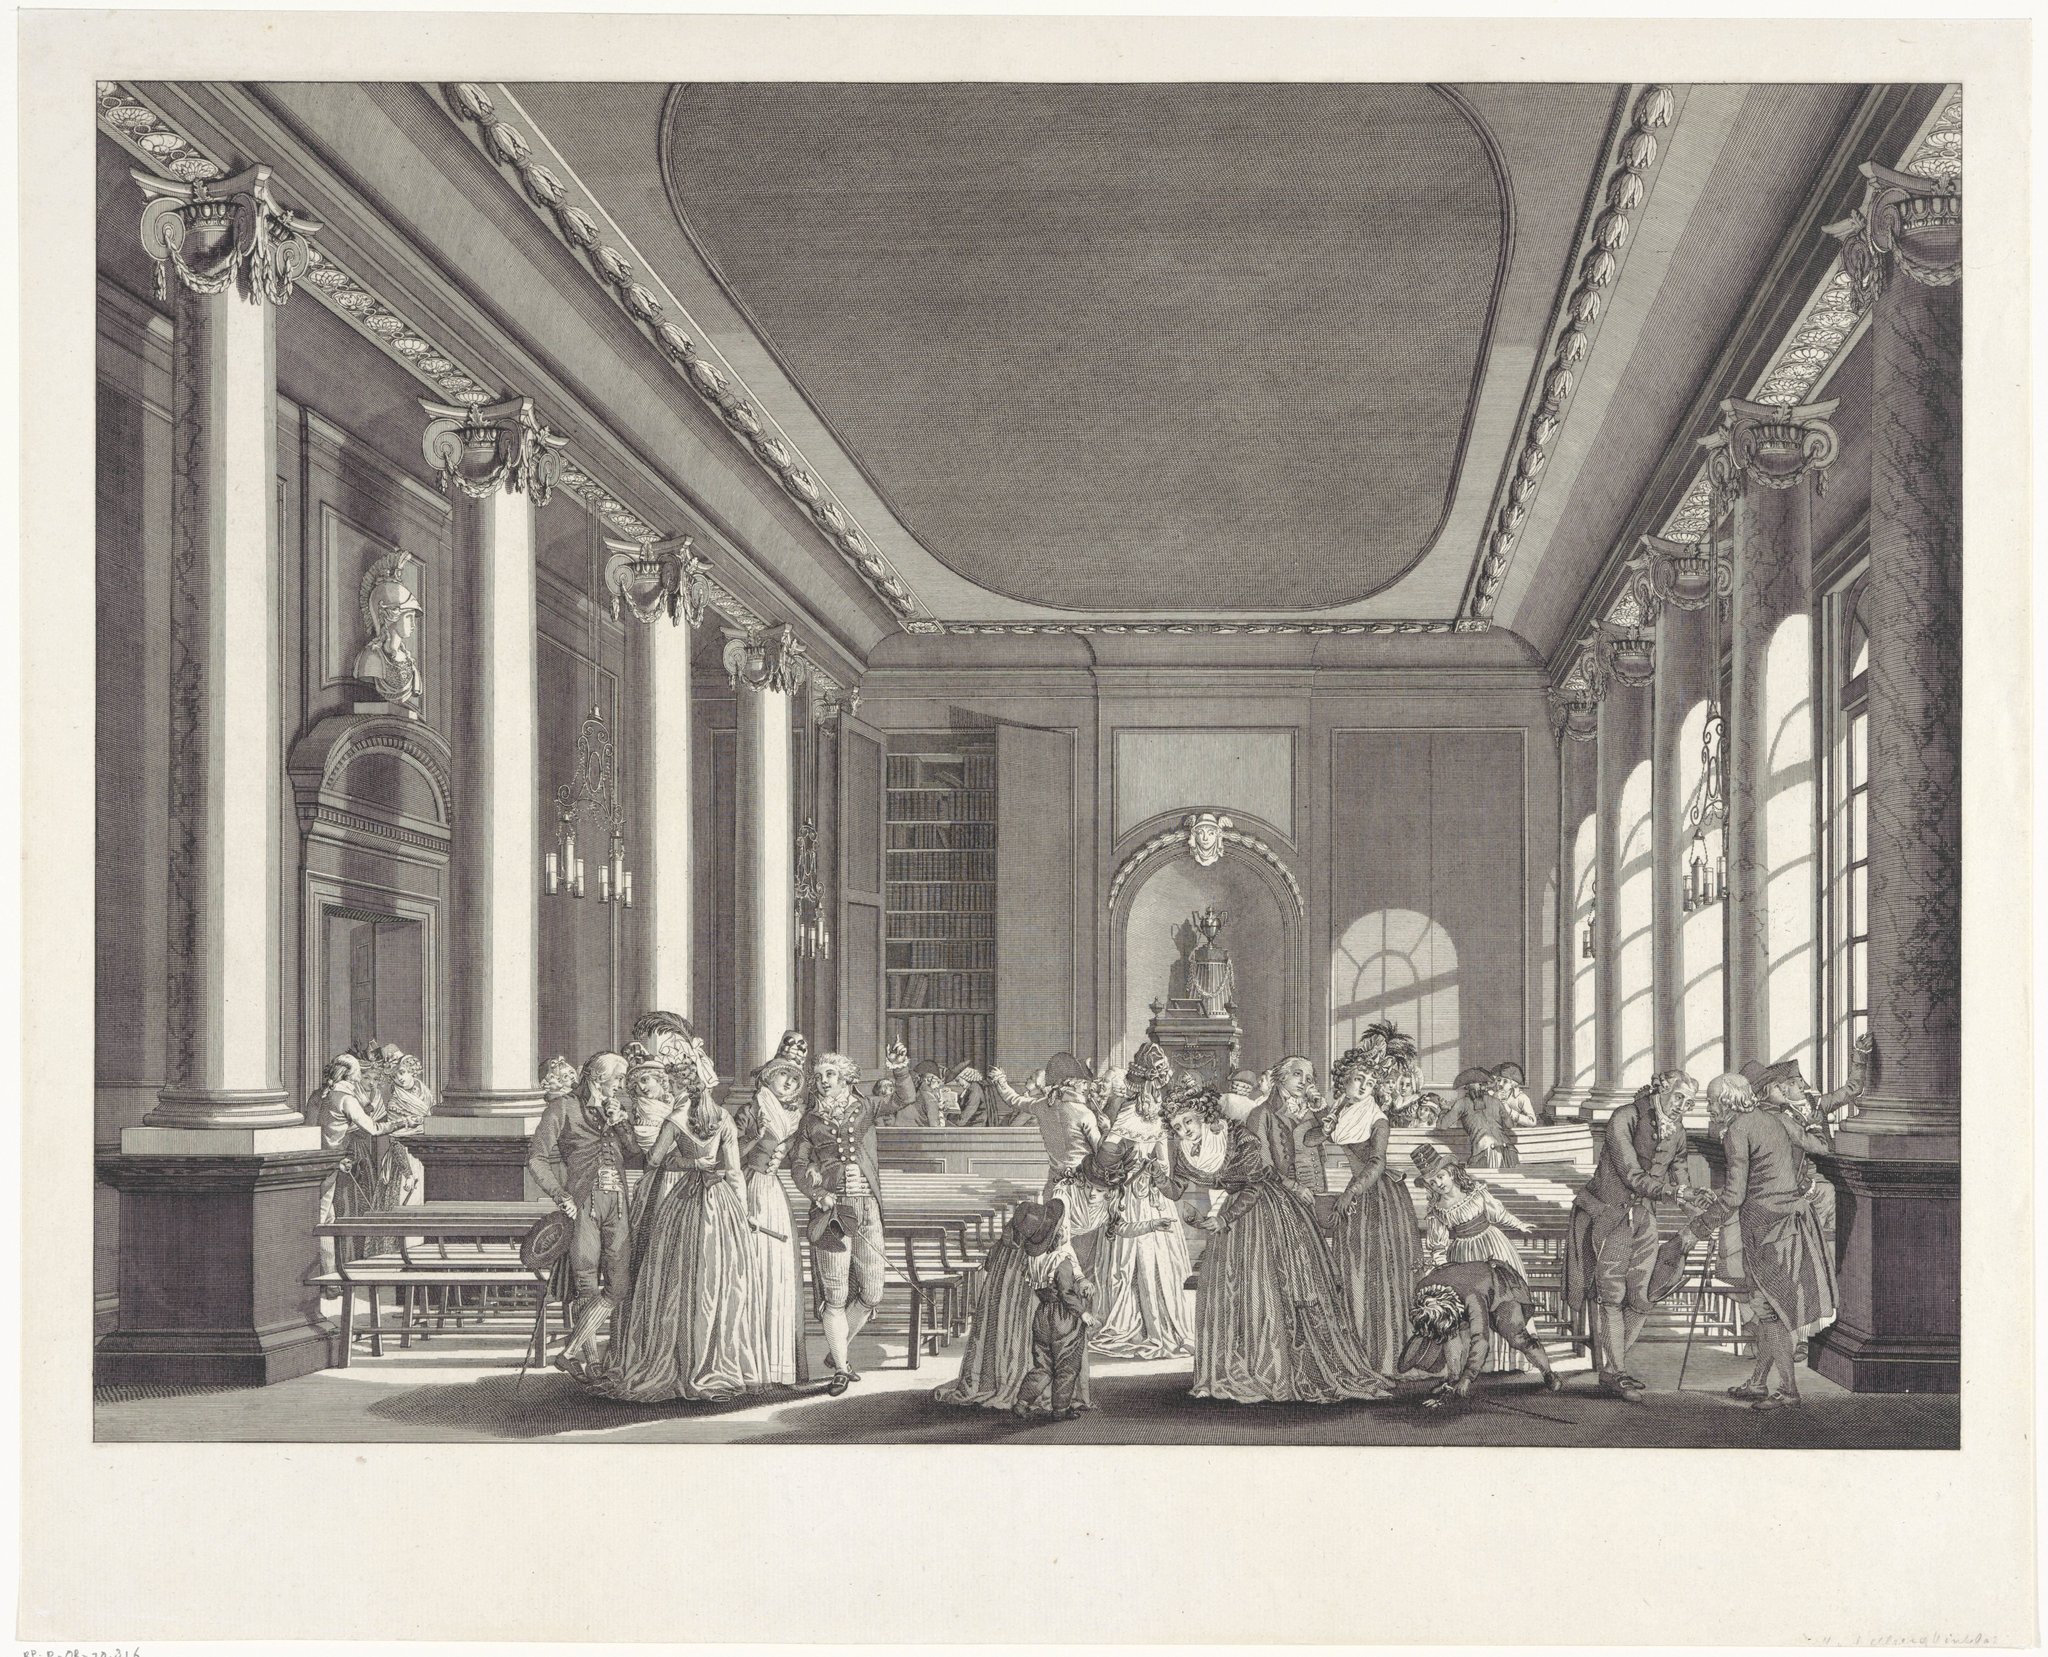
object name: print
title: Gehoorzaal in Felix Meritis, 1789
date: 1794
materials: paper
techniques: etching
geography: amsterdam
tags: learned society, academy of sciences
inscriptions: collector's mark: Lugt 2228, collector's mark: Lugt 240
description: Bezoekers in de Gehoorzaal in het gebouw van de maatschappij Felix Meritis te Amsterdam, ingewijd in 1789.